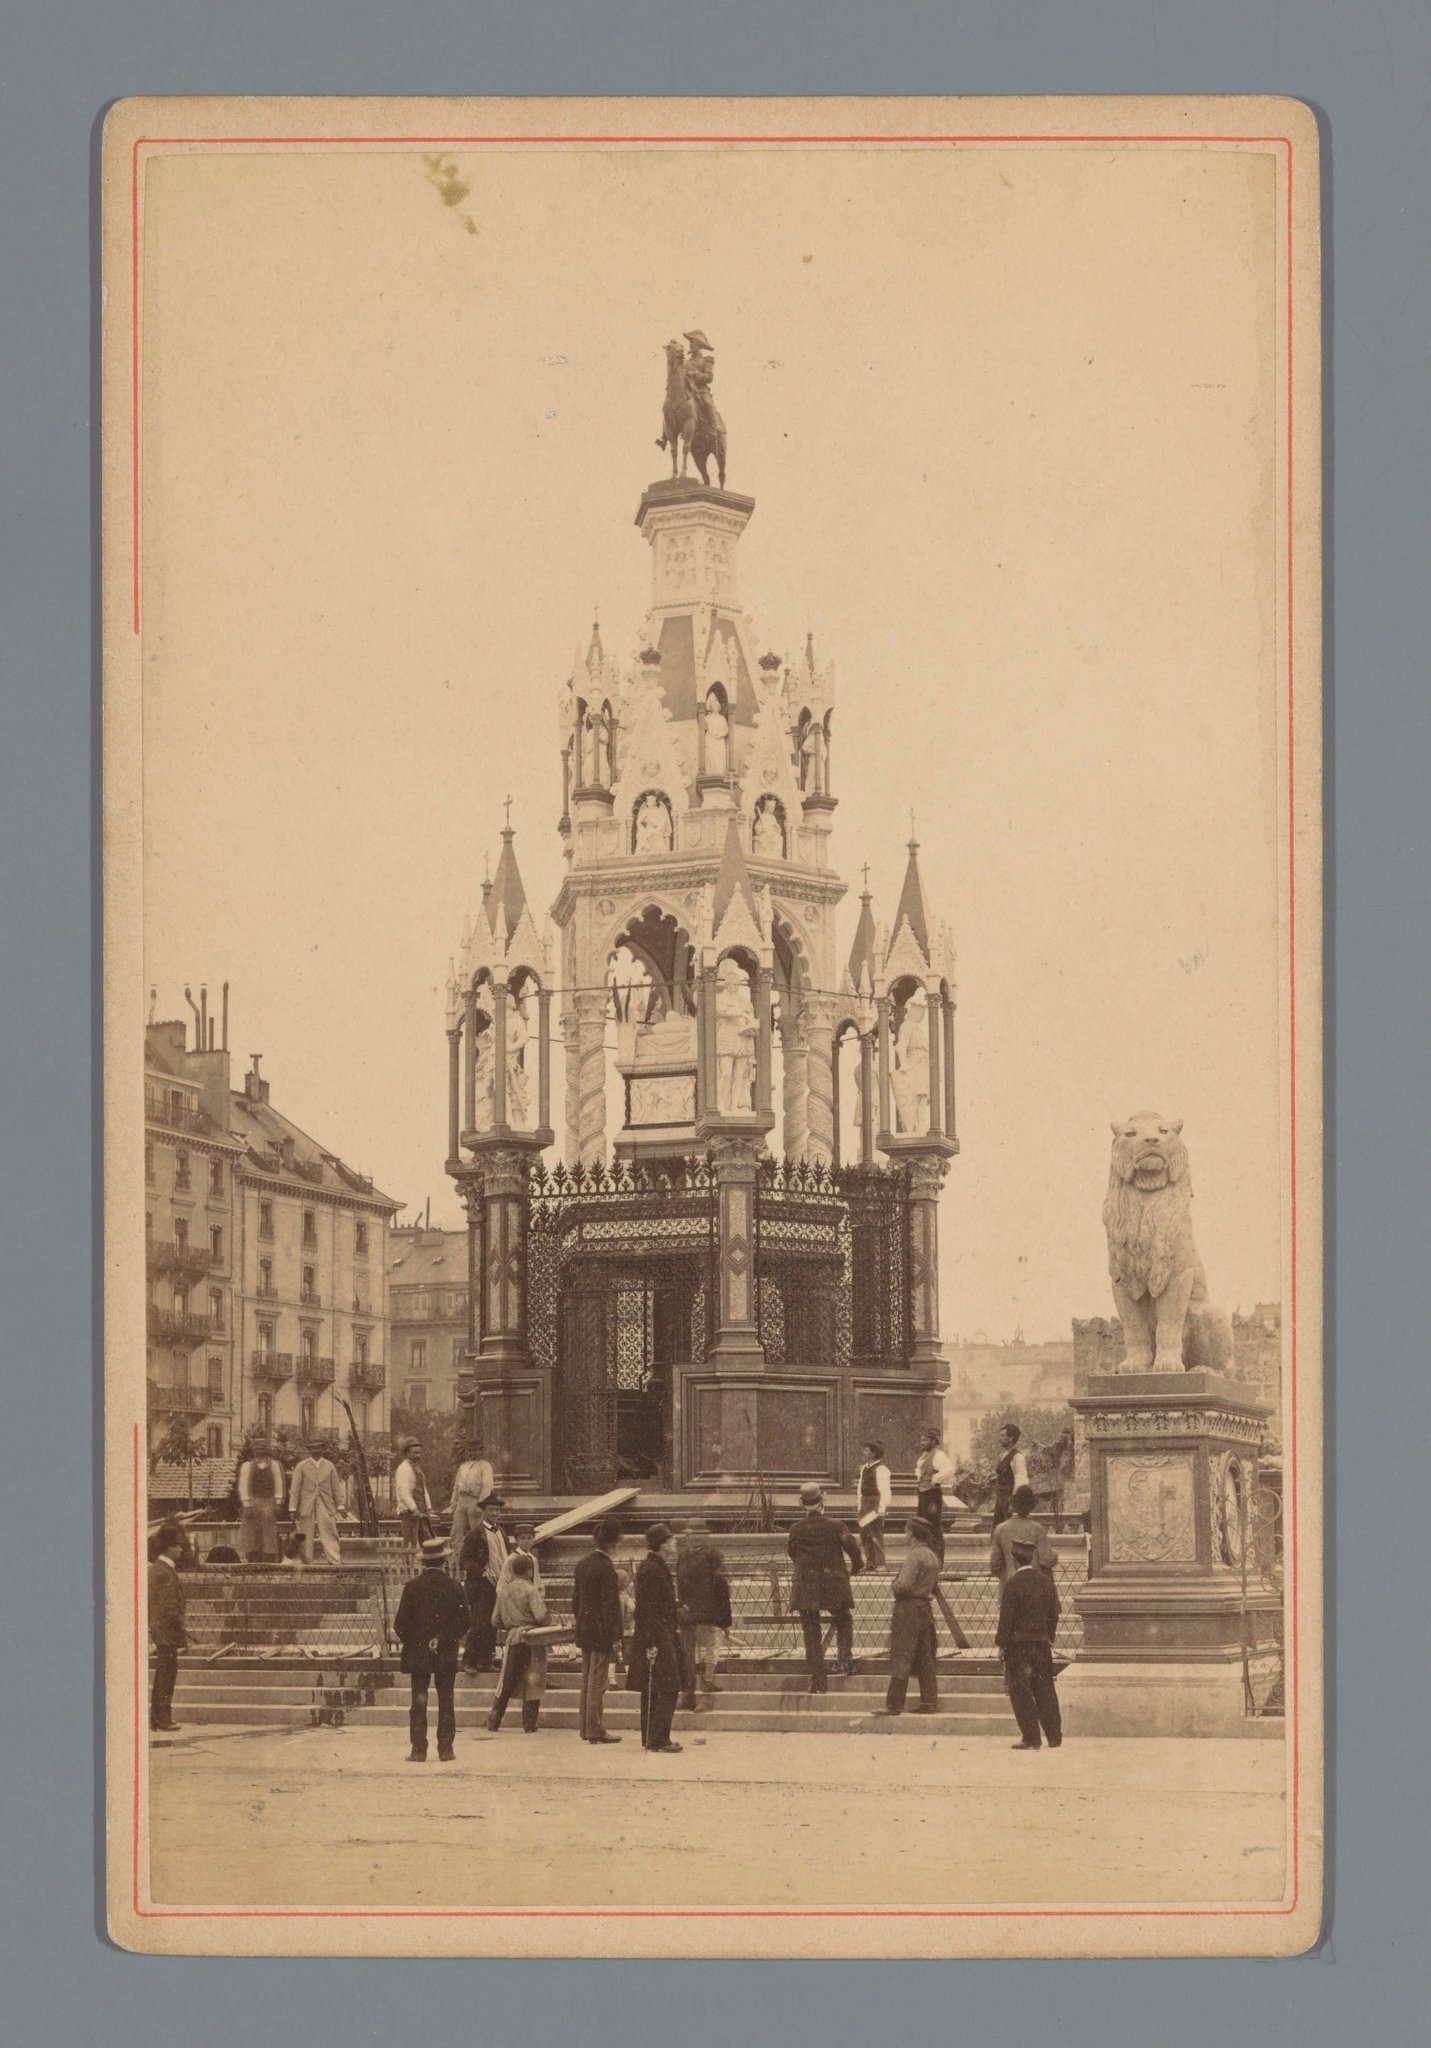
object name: cabinet photograph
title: Aanzicht van het Brunswick mausoleum in Genève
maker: garcin (prentmaker)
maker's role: print maker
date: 1879-1900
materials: cardboard, photographic support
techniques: albumen print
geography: geneva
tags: mausoleum, monument, statue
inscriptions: inscription: ‘Papeterie/ H. Bruel/ Corraterie,16/ Genève’, inscription: ‘Suisse Savoie/ Garcin/ Photographe/ A/ Geneve/ Midi de la France’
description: Monument gebouwd ter ere van Charles II, hertog van Brunswick en qua stijl een replica van de Scaliger graftombe in Verona.